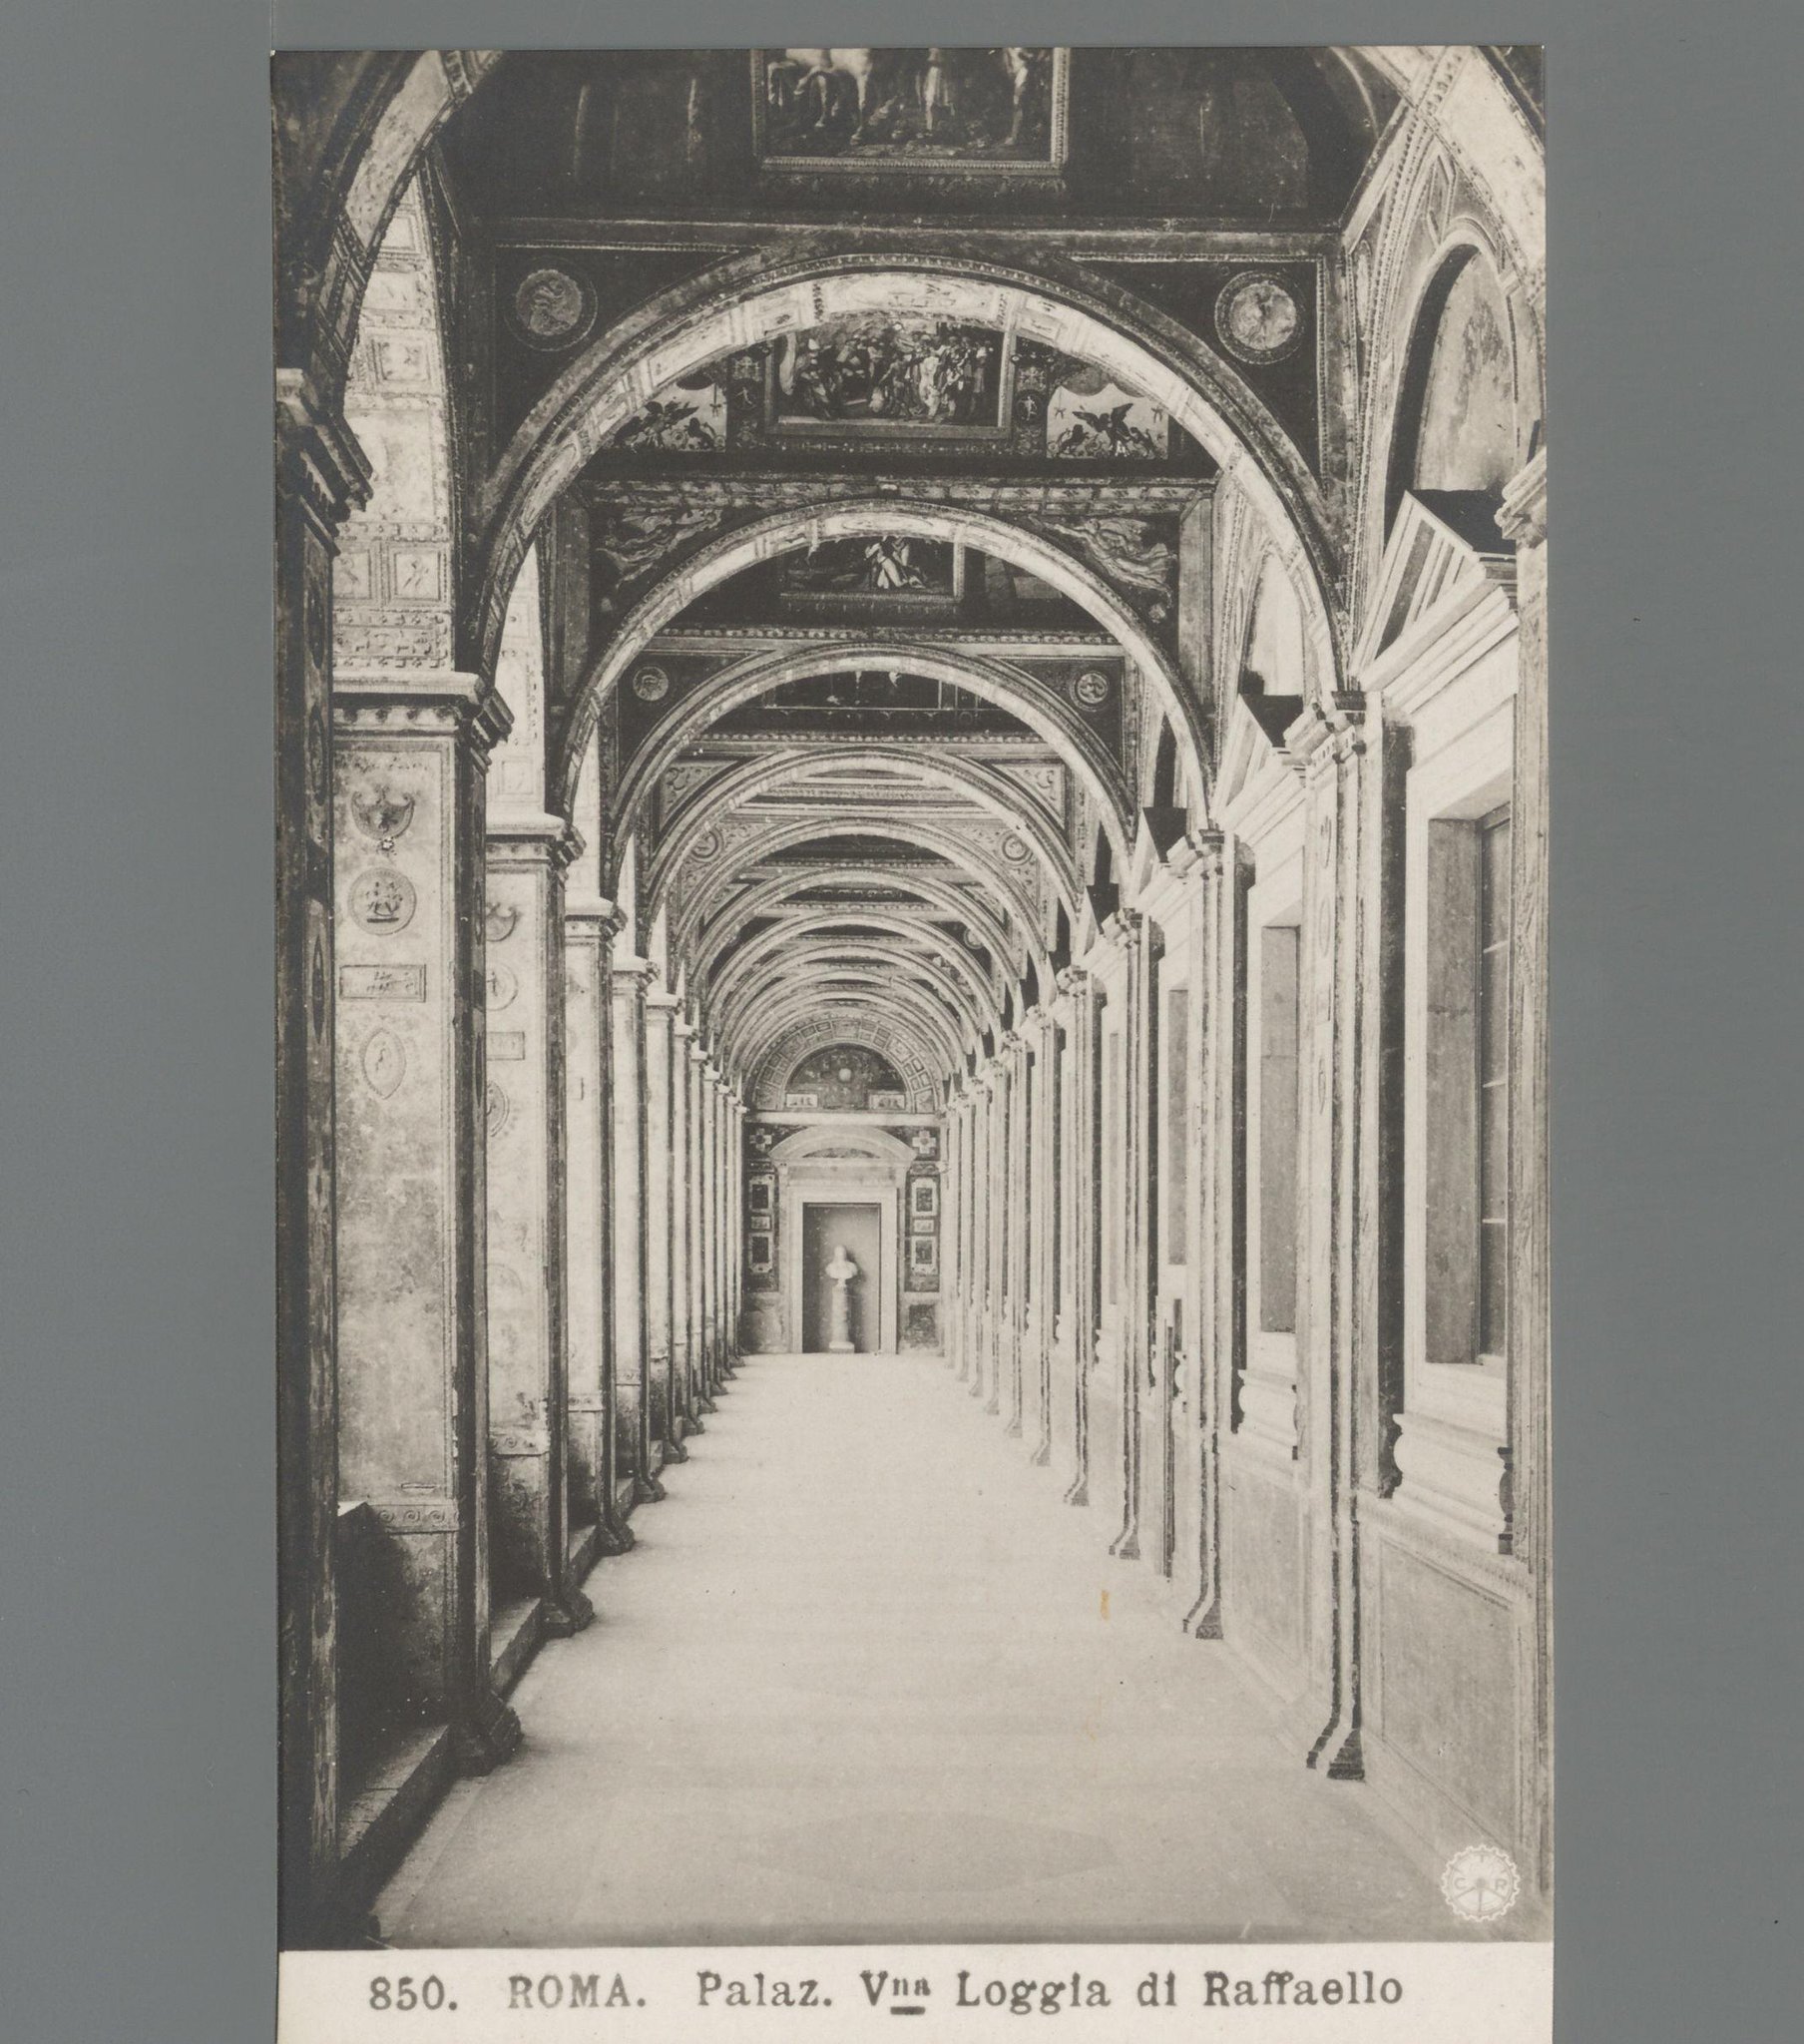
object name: ansichtkaart, prentbriefkaart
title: Roma. Palaz. Vna. Loggia di Raffaello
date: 1906-1920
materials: photographic support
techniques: photography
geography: rome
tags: loggia, verandah, porch